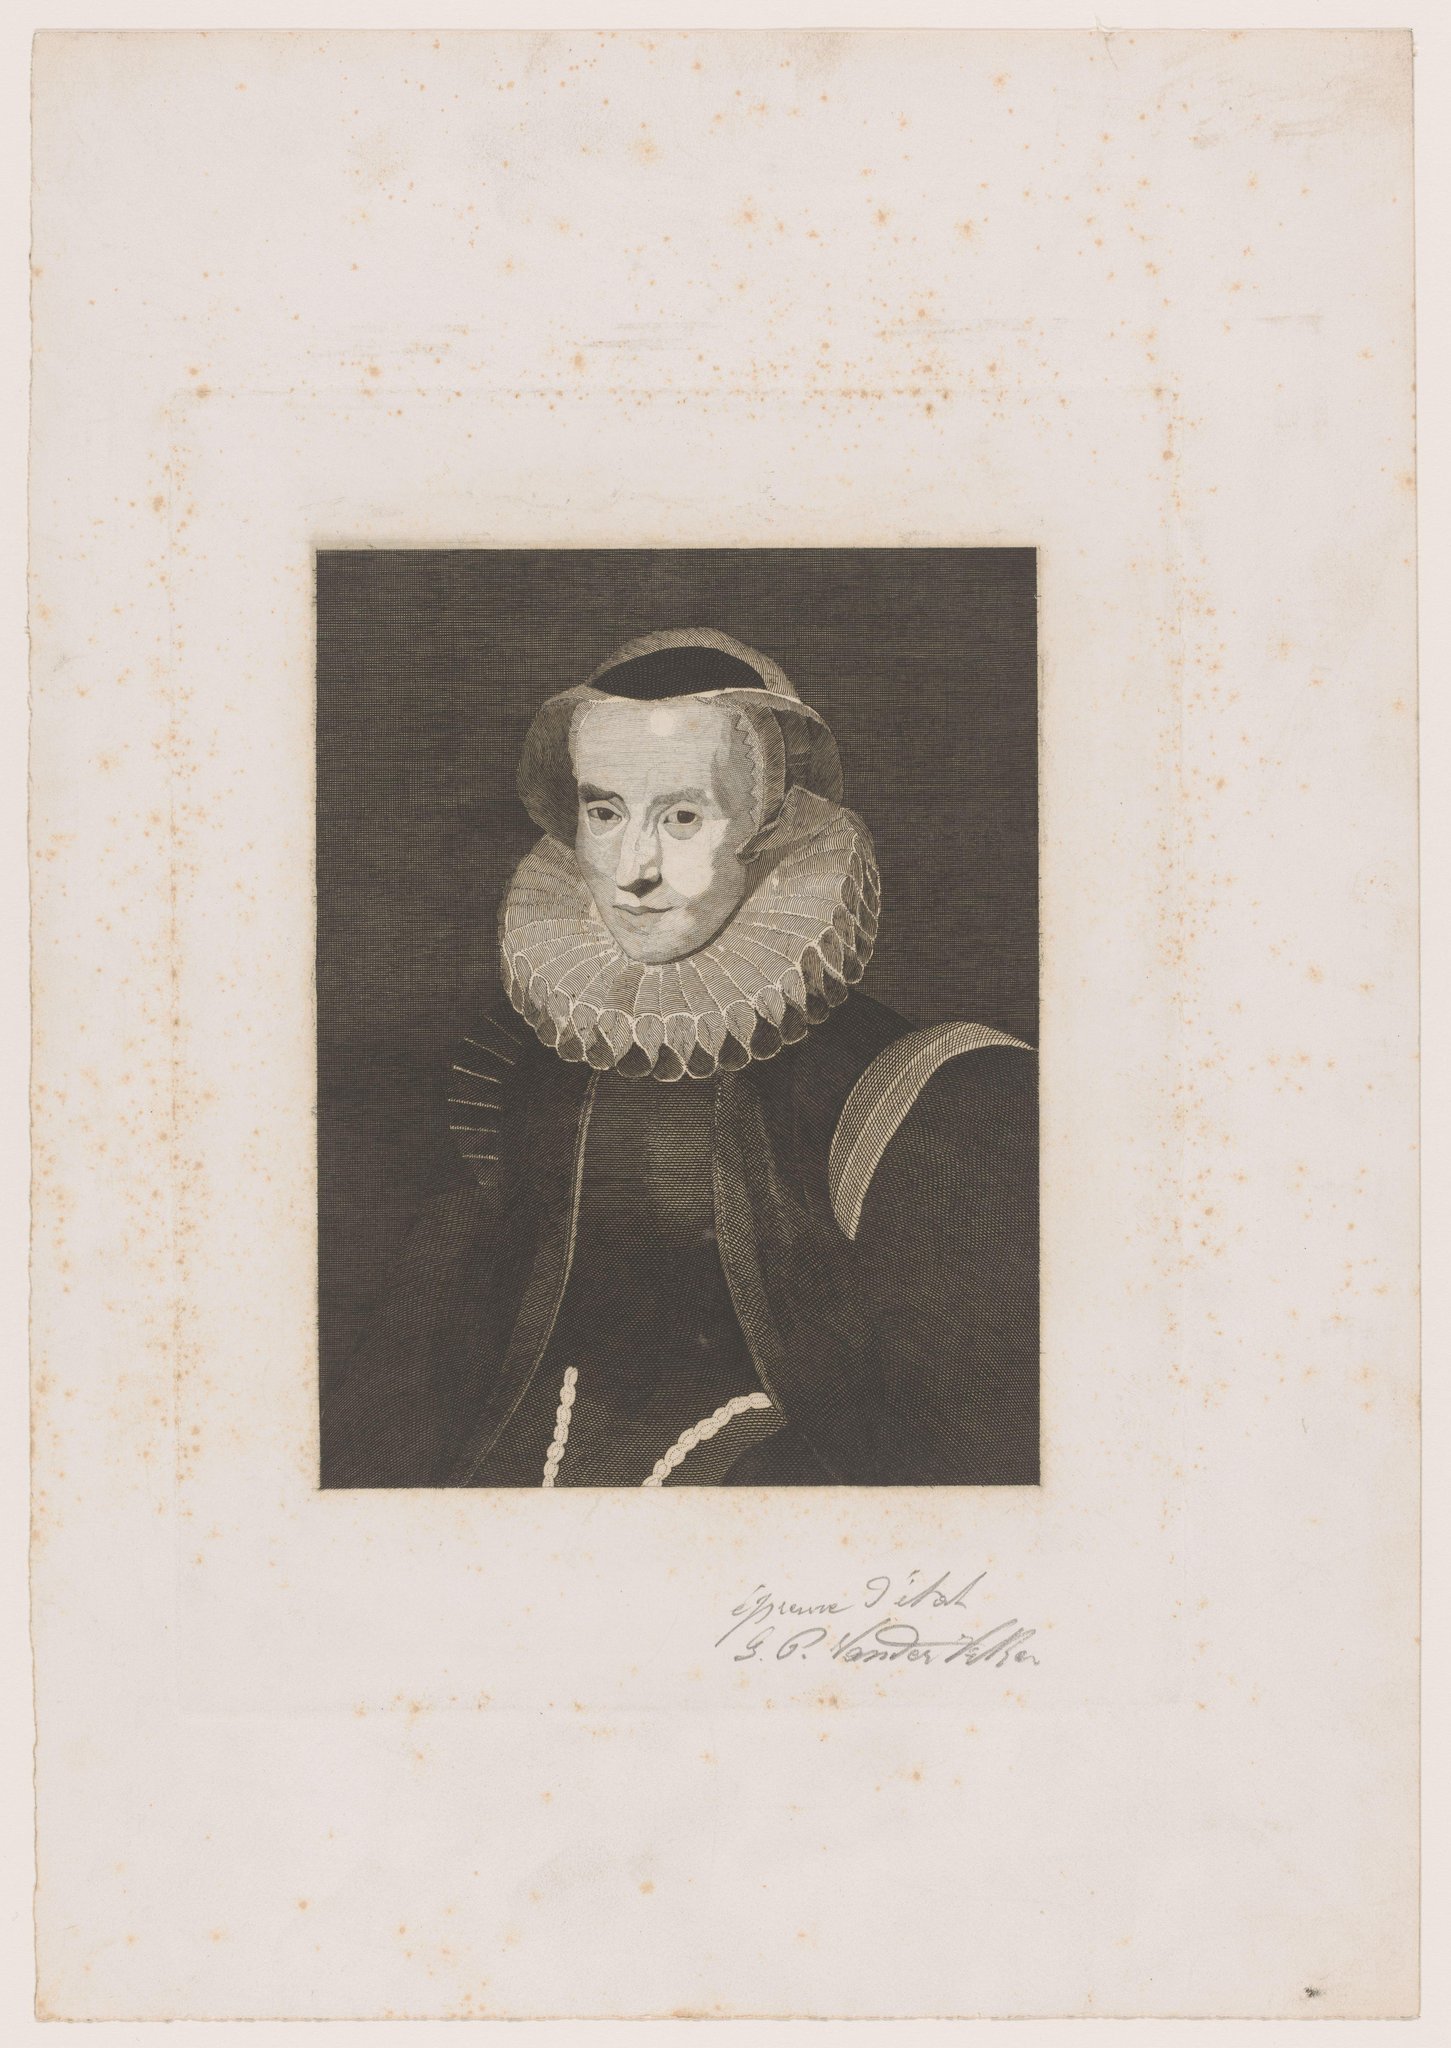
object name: print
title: Portret van een onbekende vrouw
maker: willem philip van der veken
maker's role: print maker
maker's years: 1863-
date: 1873-1899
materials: paper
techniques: engraving, etching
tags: adult woman, historical persons, neck-gear: collar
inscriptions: inscription: ‘Épreuve d'état’, collector's mark: Lugt 2228